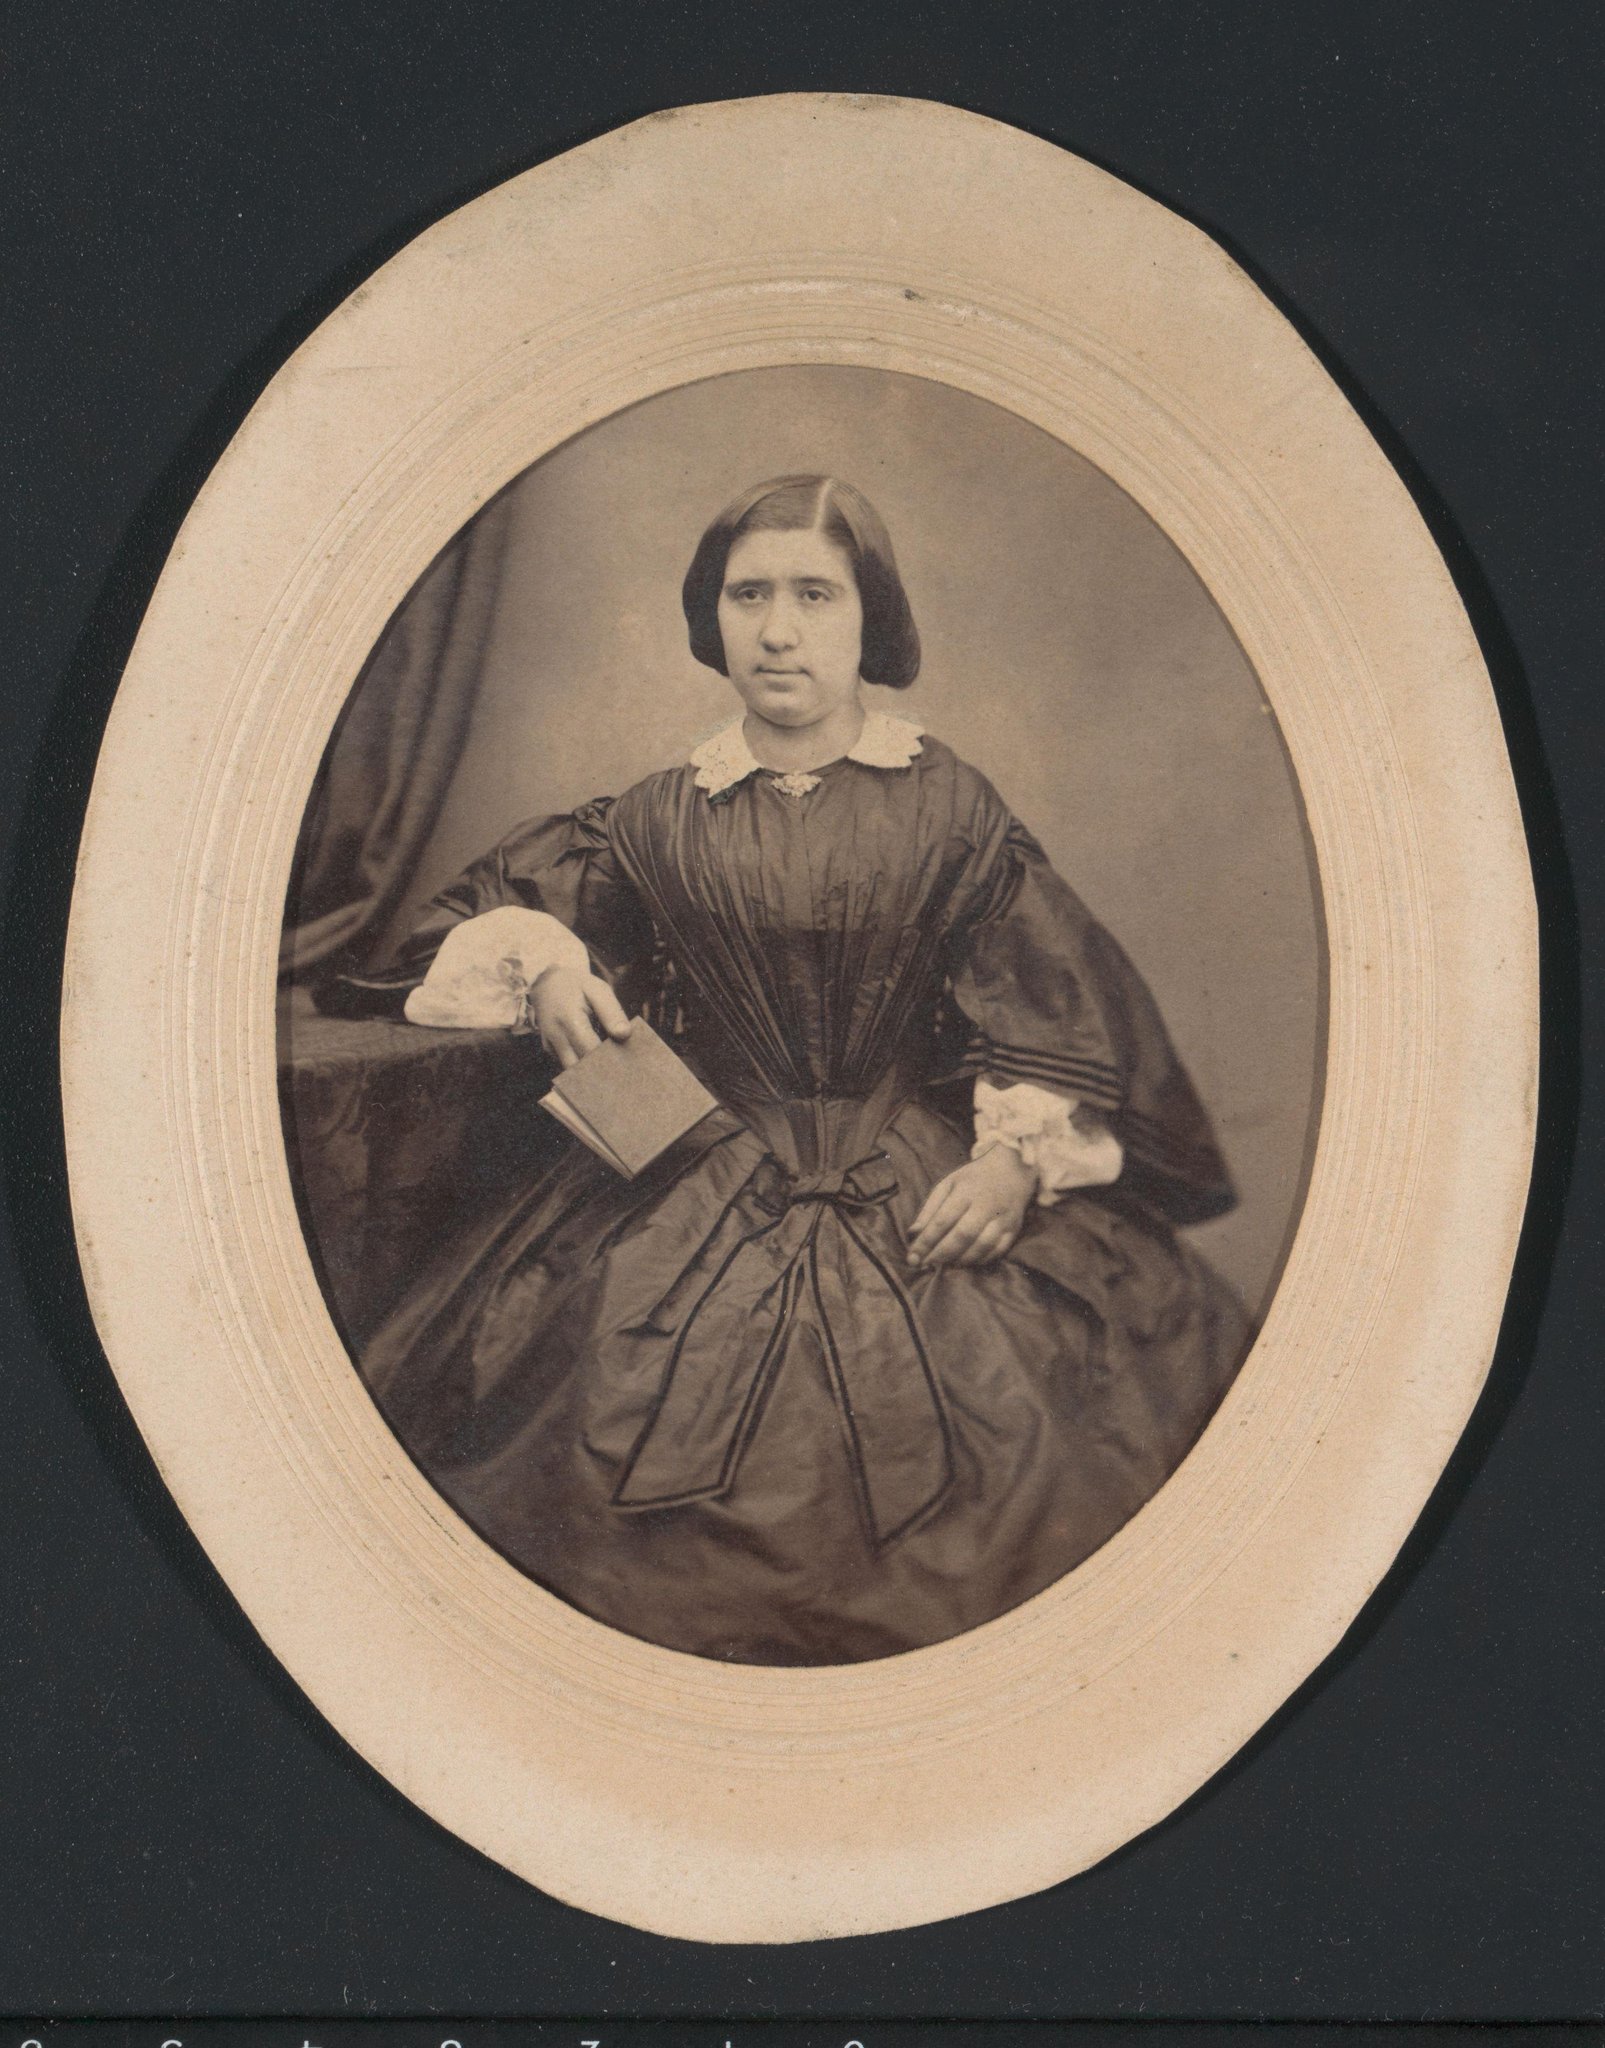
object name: photograph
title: Portret van en vrouw in een jurk met een boek in de hand, mogelijk behorend tot de familie Nathanson, Hannover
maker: Anonymous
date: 1855-1860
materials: cardboard, paper, photographic support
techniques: albumen print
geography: hannover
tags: studio requisites ~ photographer, historical persons not known by name - bb - woman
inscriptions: inscription: ‘uit pakket foto's familie Nathanson-Hannover’